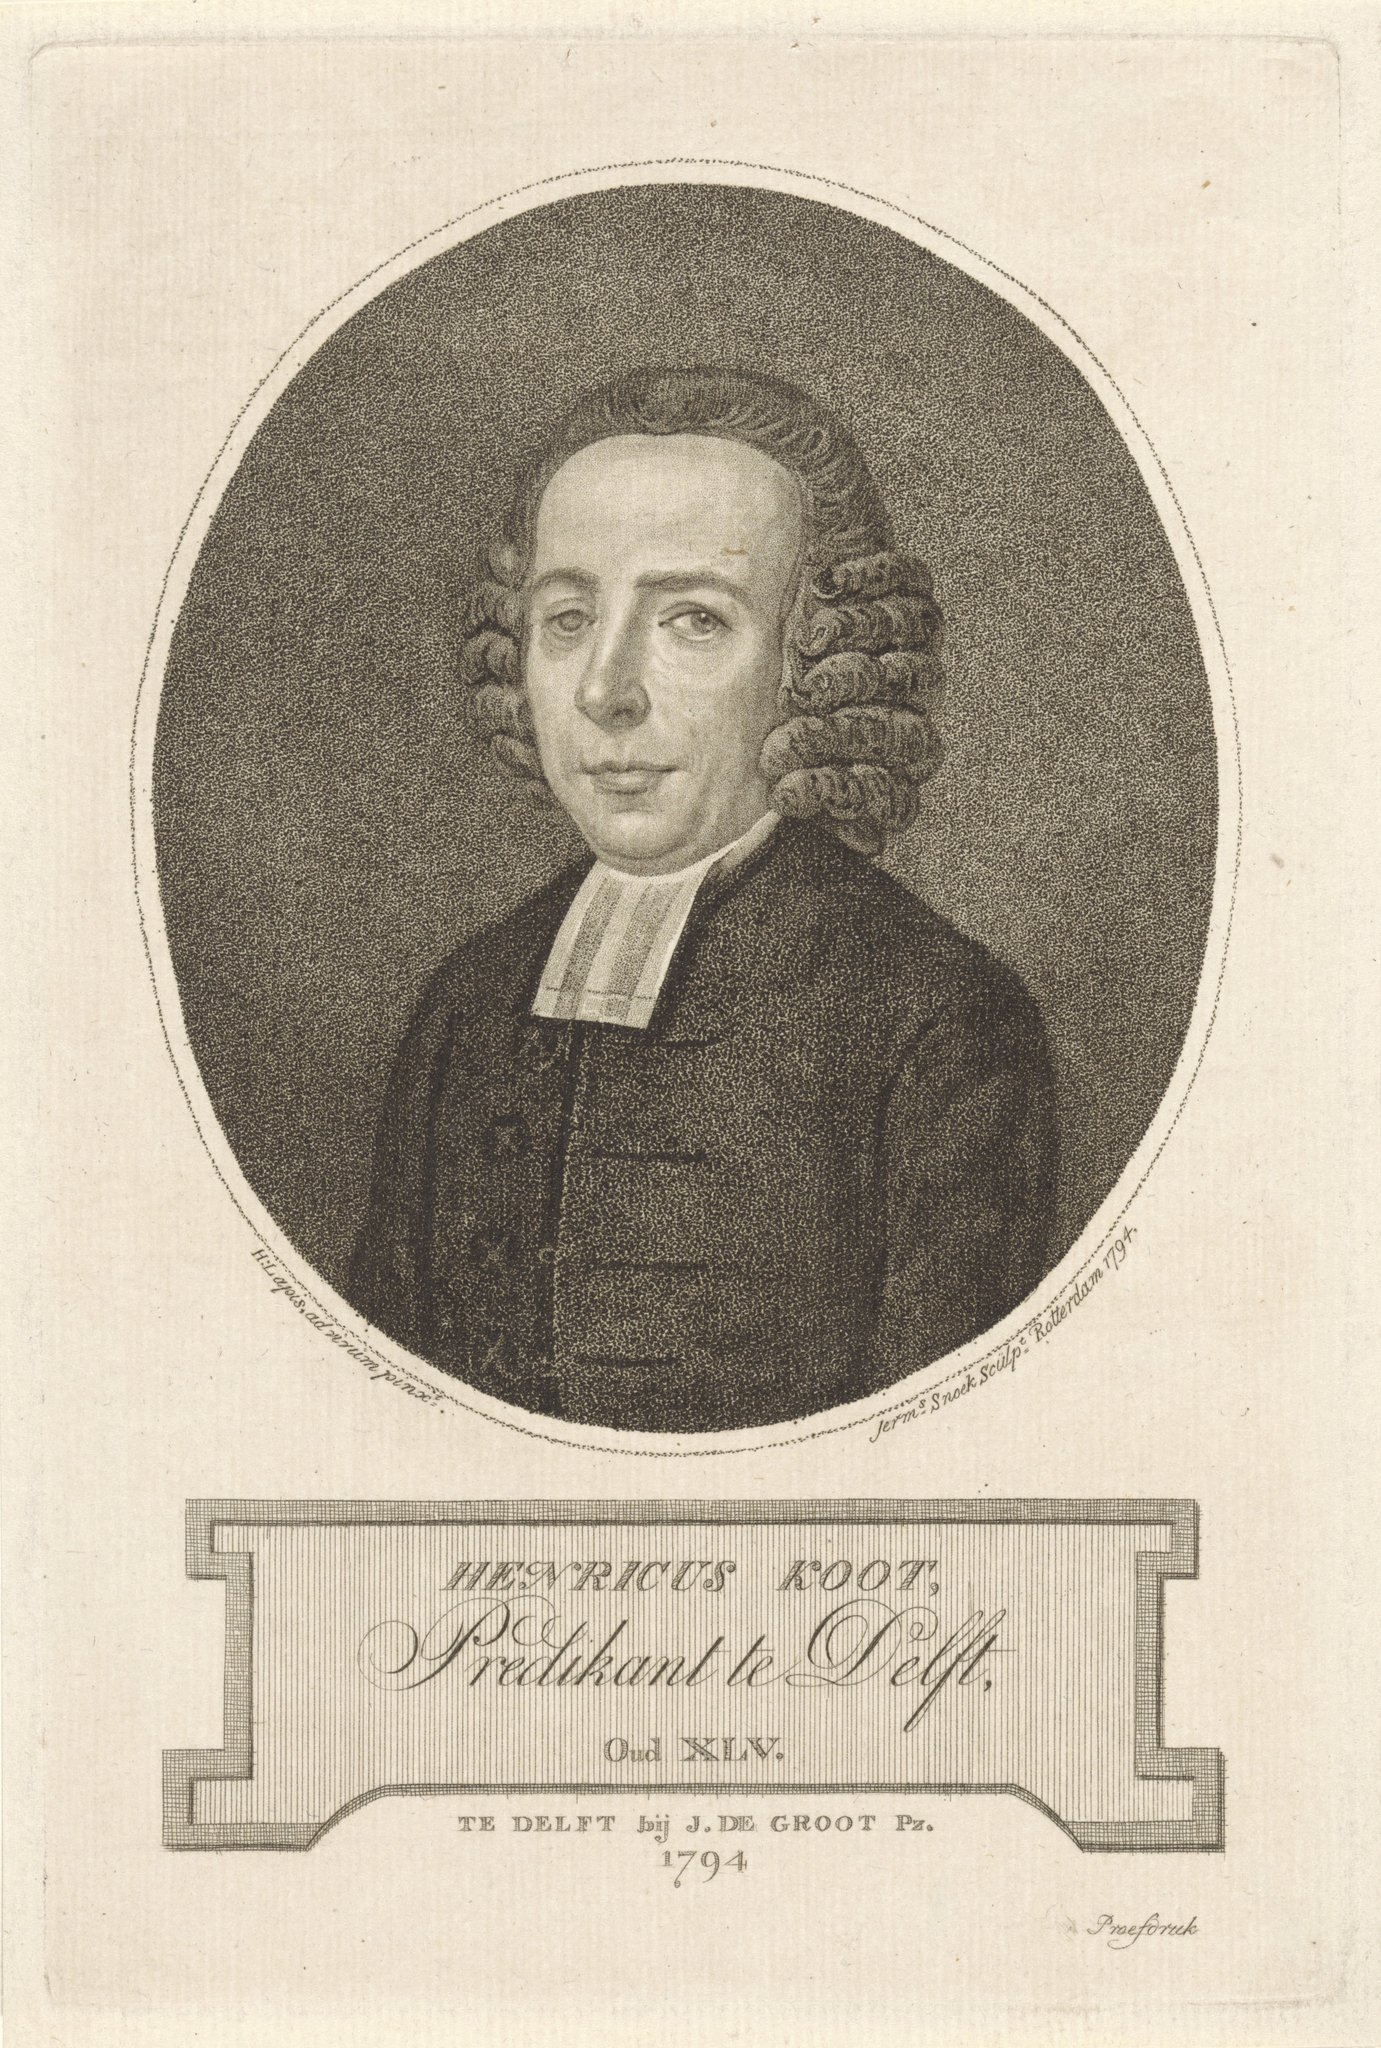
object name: print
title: Portret van Henricus Koot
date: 1794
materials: paper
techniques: etching, engraving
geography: delft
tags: predikant, henricus koot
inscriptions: collector's mark: Lugt 2228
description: Portret van de delftse predikant Henricus Koot. Onder het portret staan in een cartouche zijn naam, leeftijd en functie.